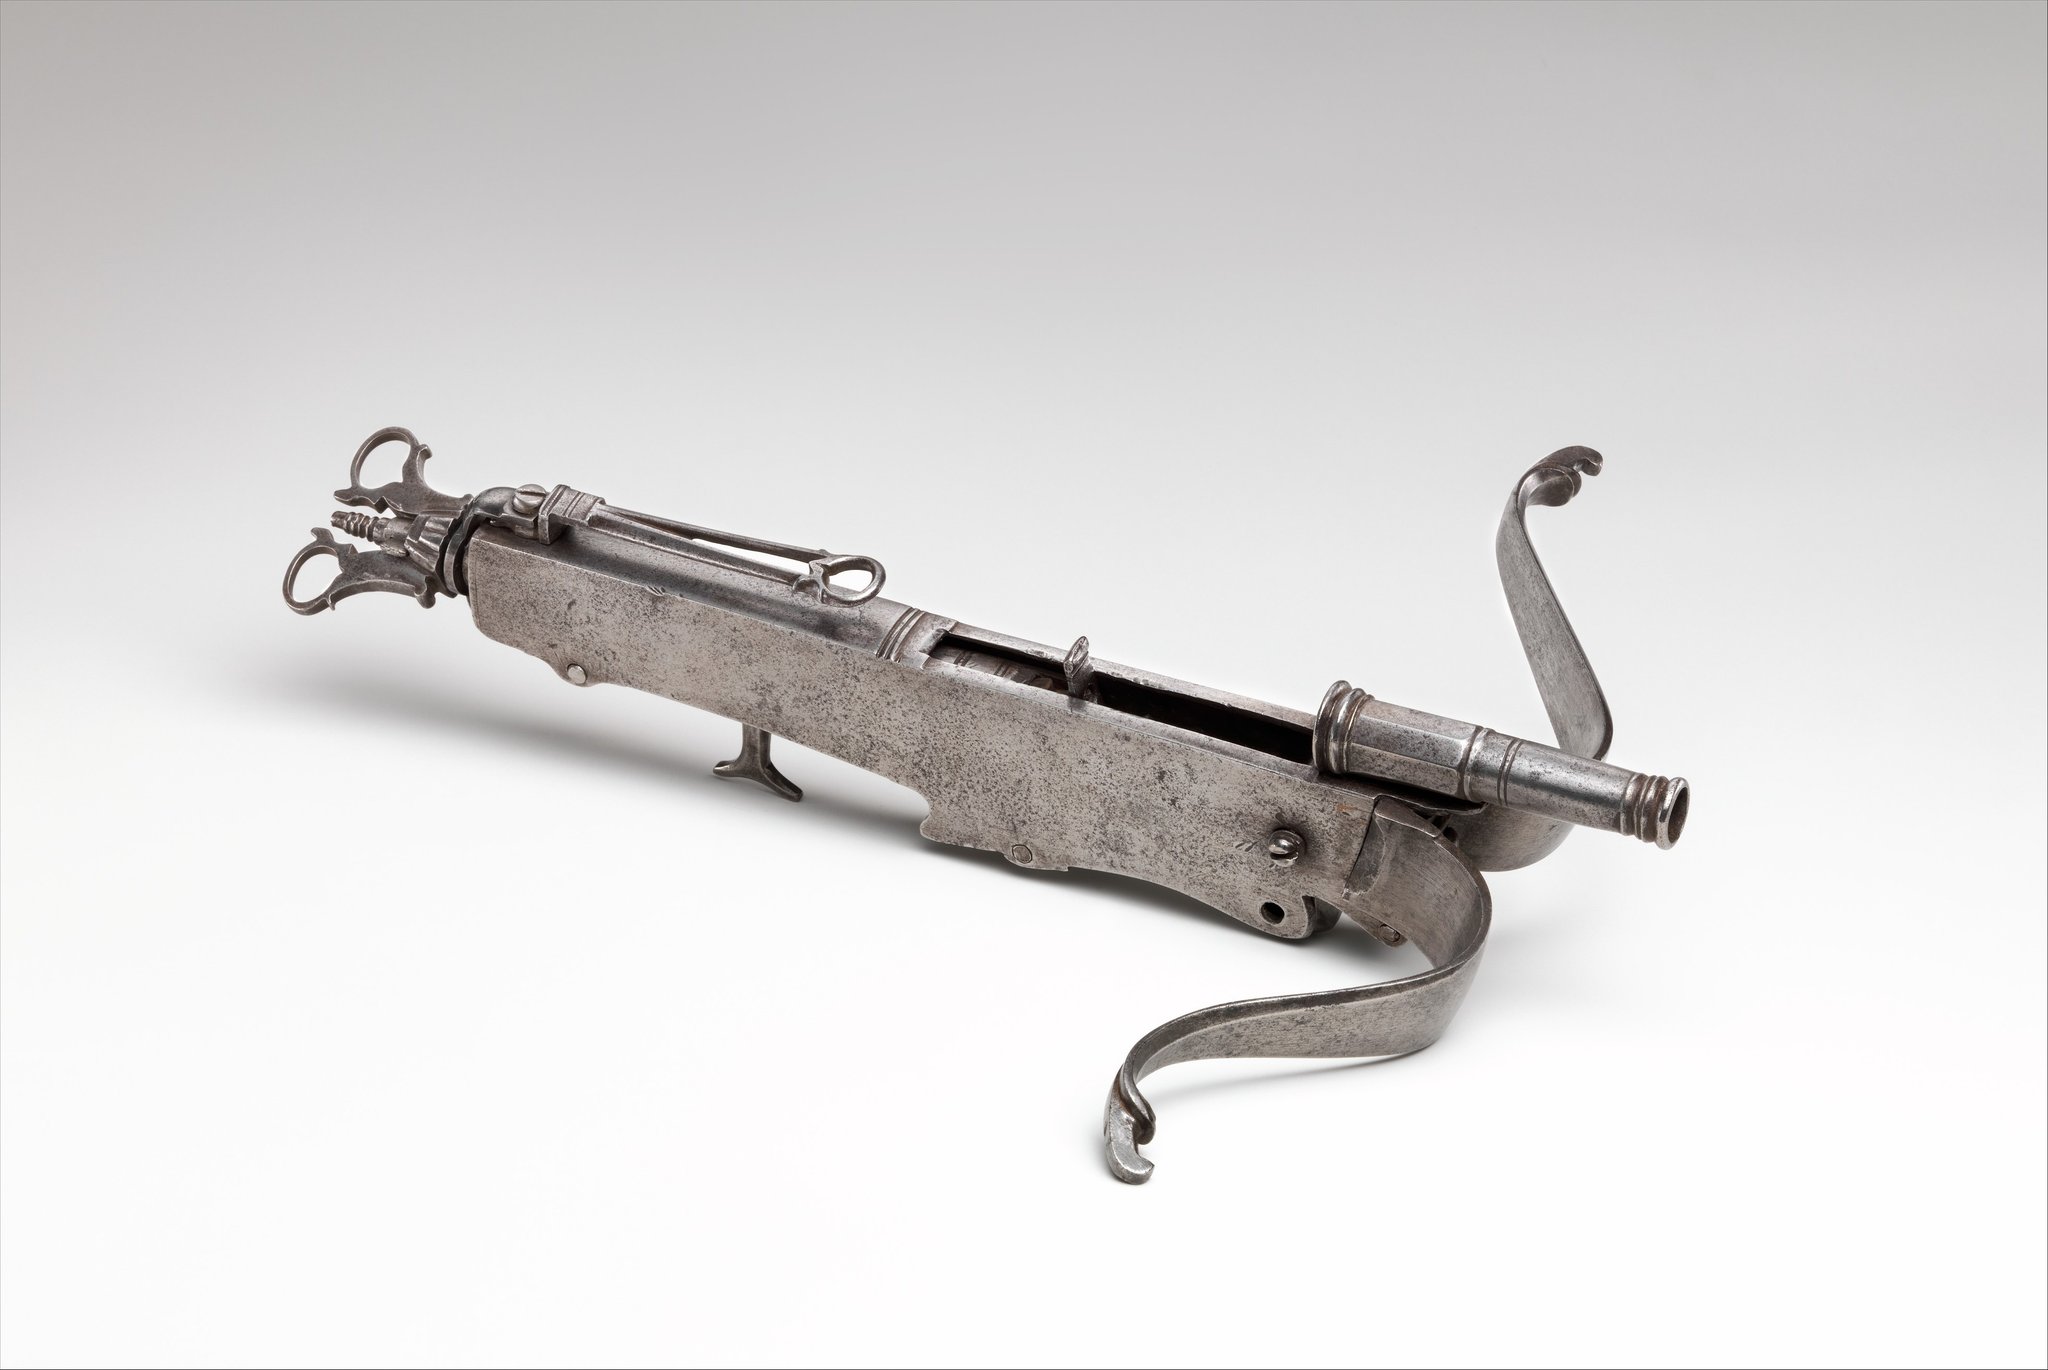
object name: small crossbow balestrino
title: Small Crossbow (Balestrino)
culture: italian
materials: steel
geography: italy